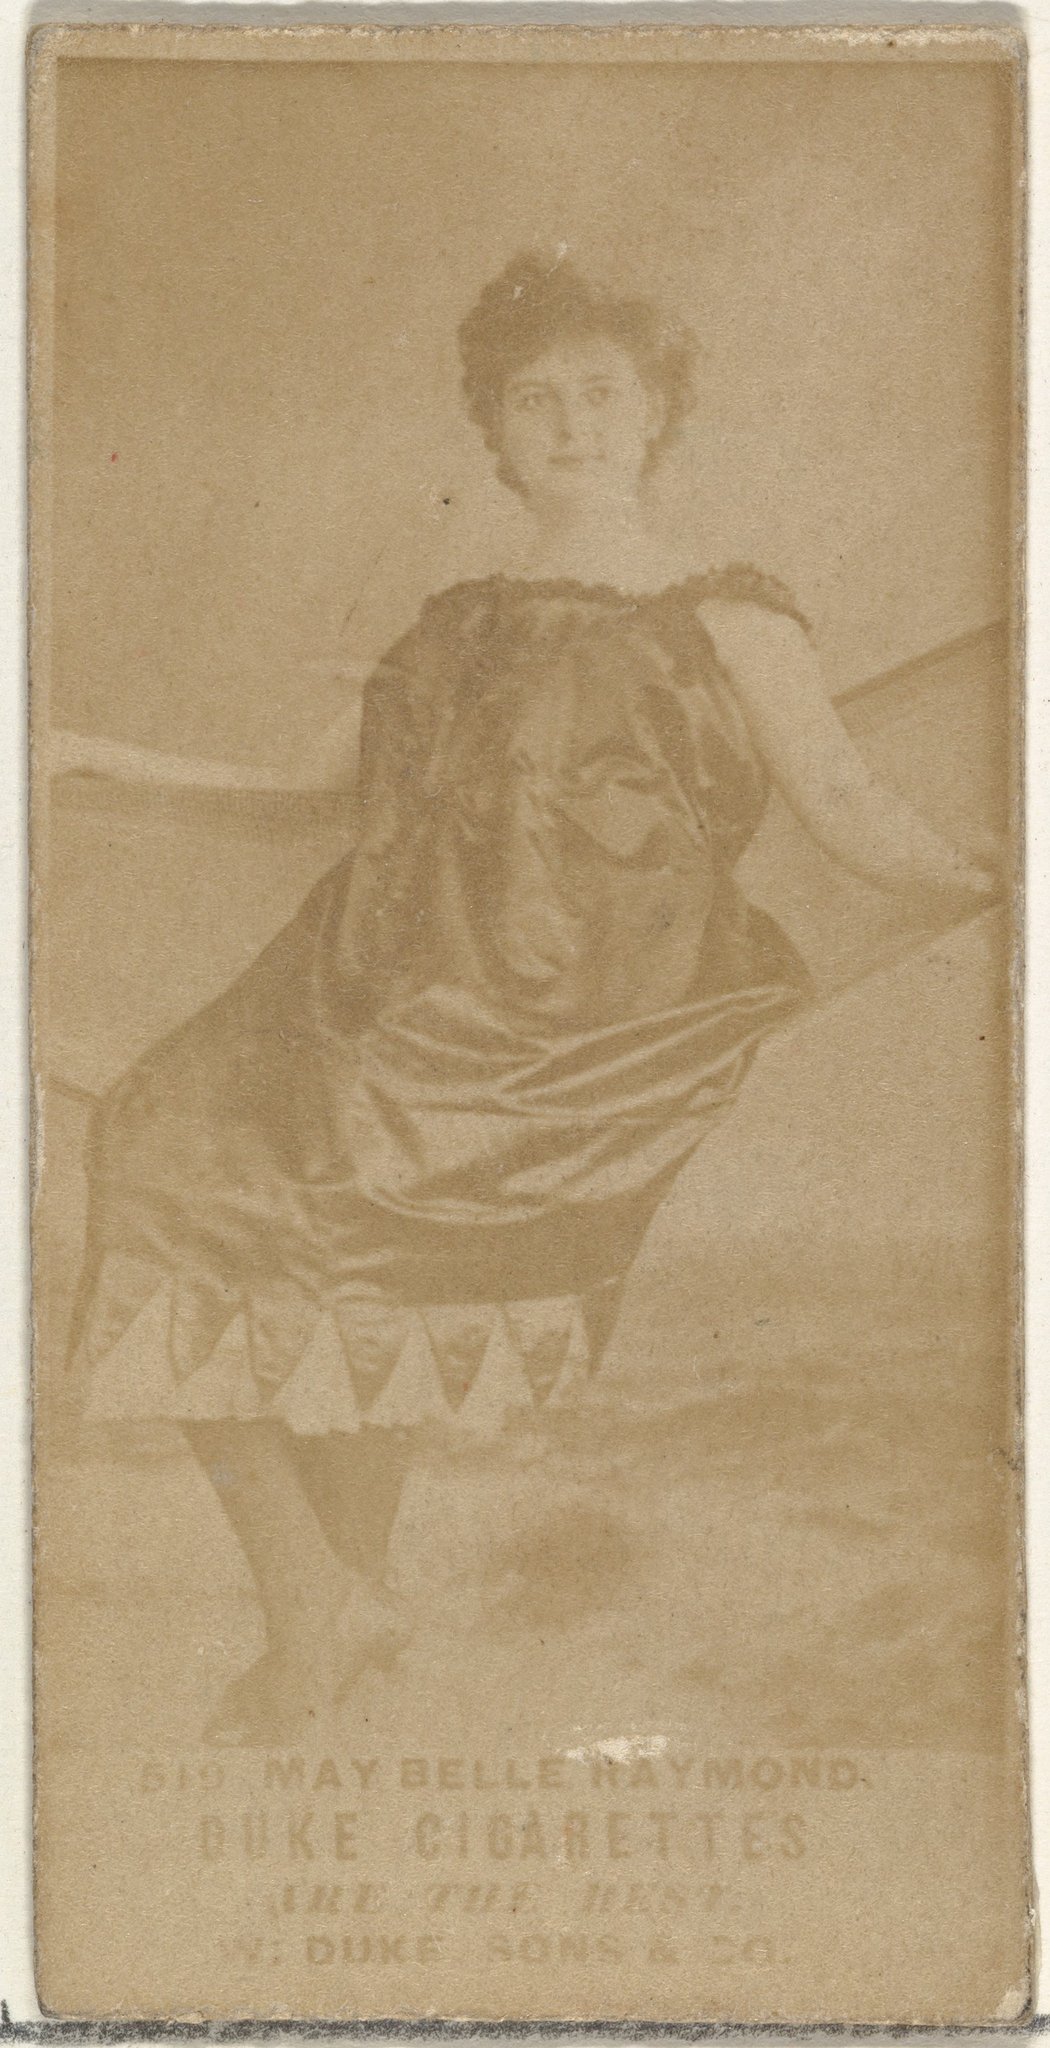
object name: photograph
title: Card Number 519, May Belle Raymond, from the Actors and Actresses series (N145-7) issued by Duke Sons & Co. to promote Duke Cigarettes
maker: w. duke, sons & co.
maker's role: publisher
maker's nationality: american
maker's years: 1870-1920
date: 1880-1889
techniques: albumen silver print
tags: portraits,women,actresses